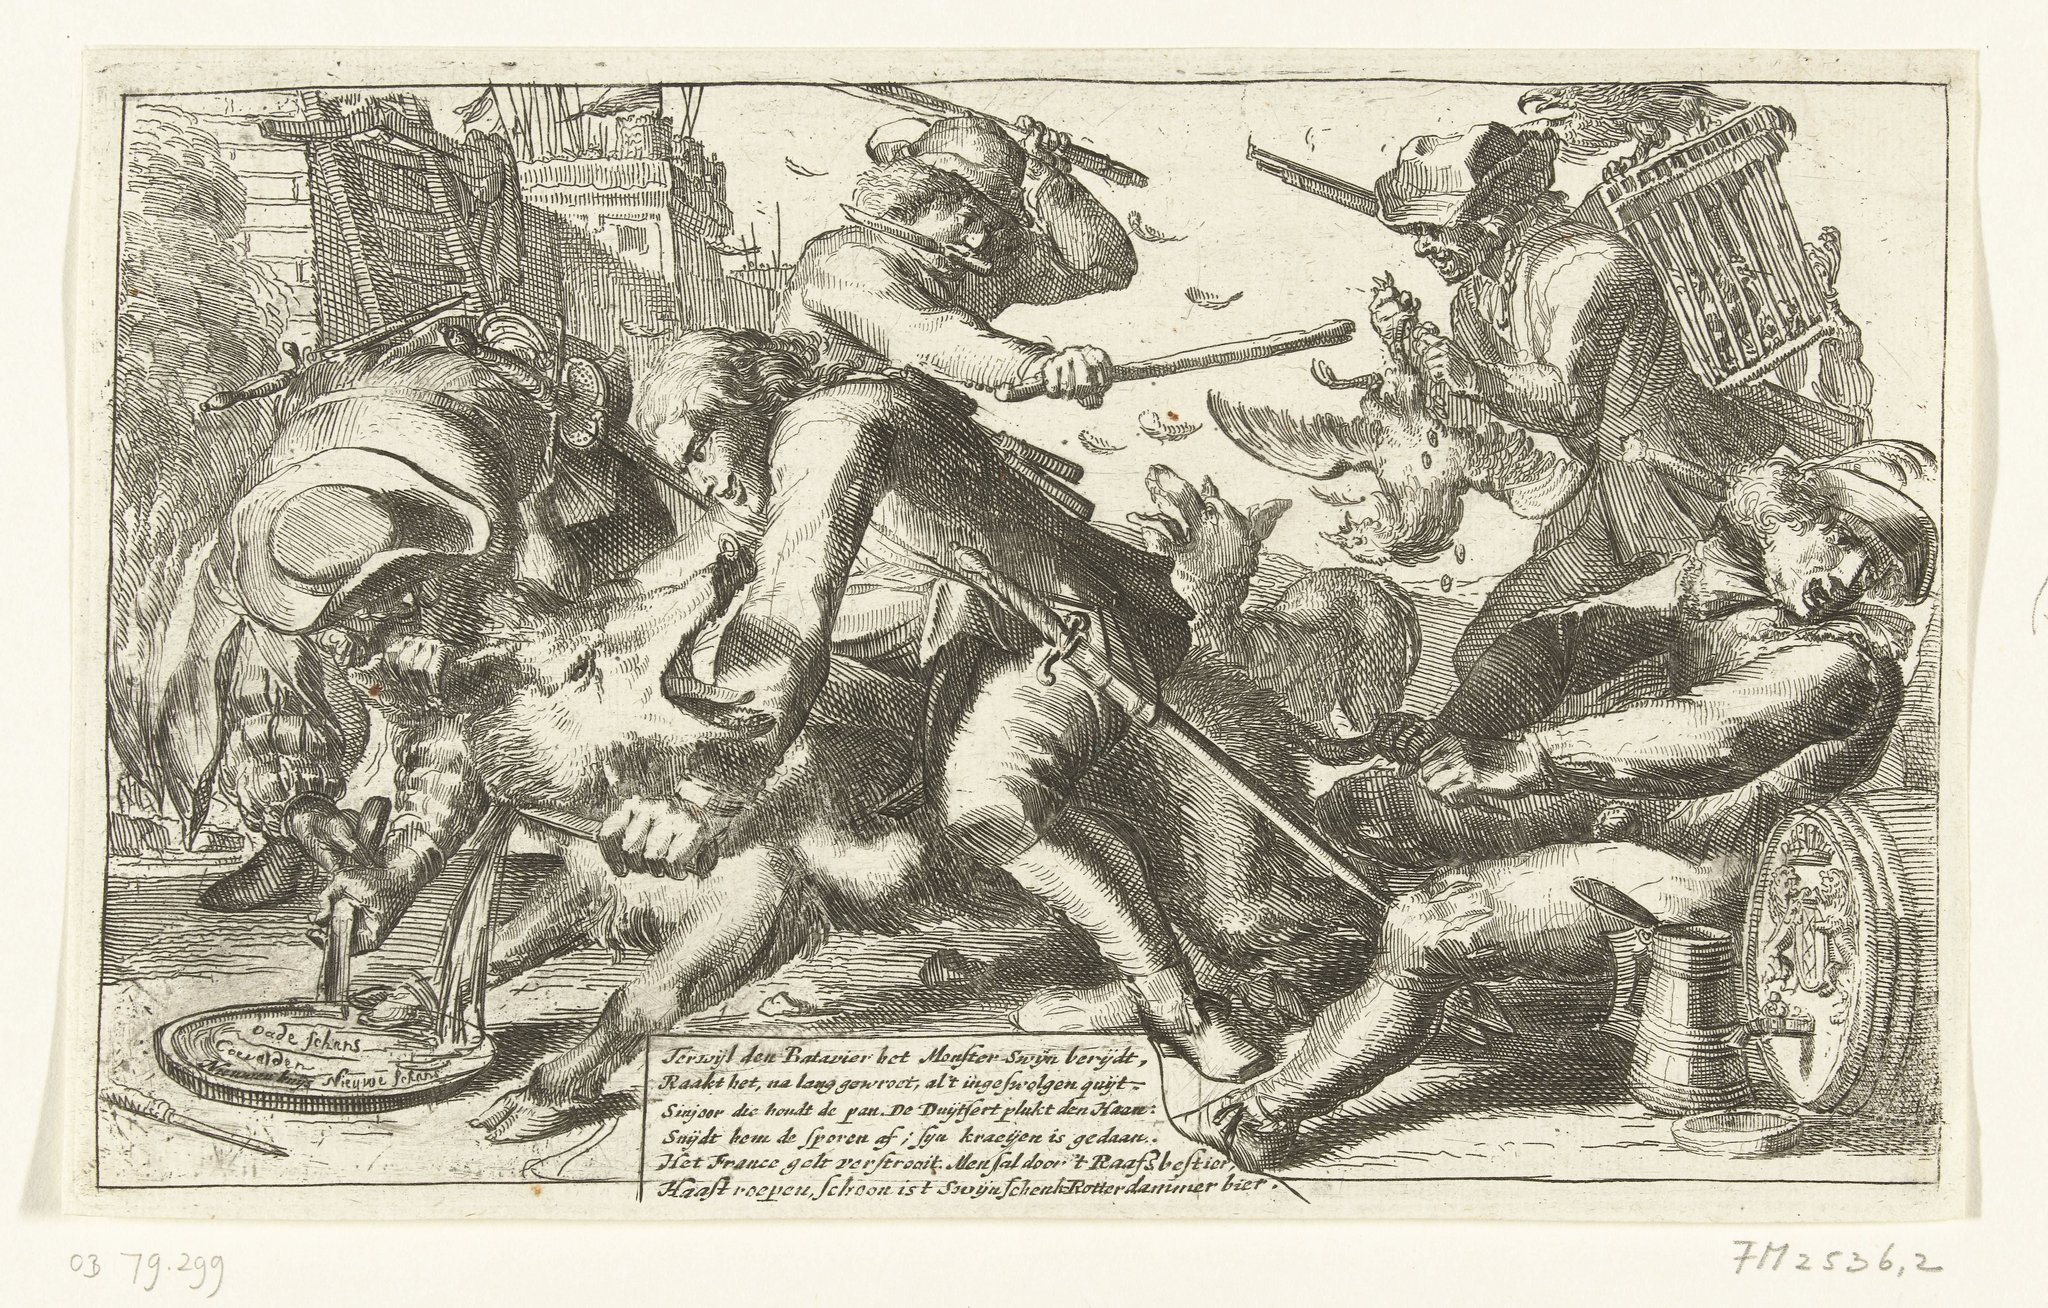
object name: print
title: Spotprenten op Frankrijk, Münster en Keulen na het sluiten van de vrede met Engeland in 1674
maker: romeyn de hooghe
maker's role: draughtsman, goldsmith, painter, print maker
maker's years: 1645-1708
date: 1674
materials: paper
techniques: etching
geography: northern netherlands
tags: maximiliaan hendrik van beieren, political caricatures and satires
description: Spotprent op Münster (en Keulen) na het sluiten van de vrede tussen de Republiek en Engeland, 1674. Een Hollander snijdt een zwijn (Münster) de keel door. Op de achtergrond vangt en plukt een vogelkoopman (Duitsland) de haan (Frankrijk) en wordt een wolf (Keulen) verjaagd. Middenonder een cartouche met een vers van 6 regels in het Nederlands.